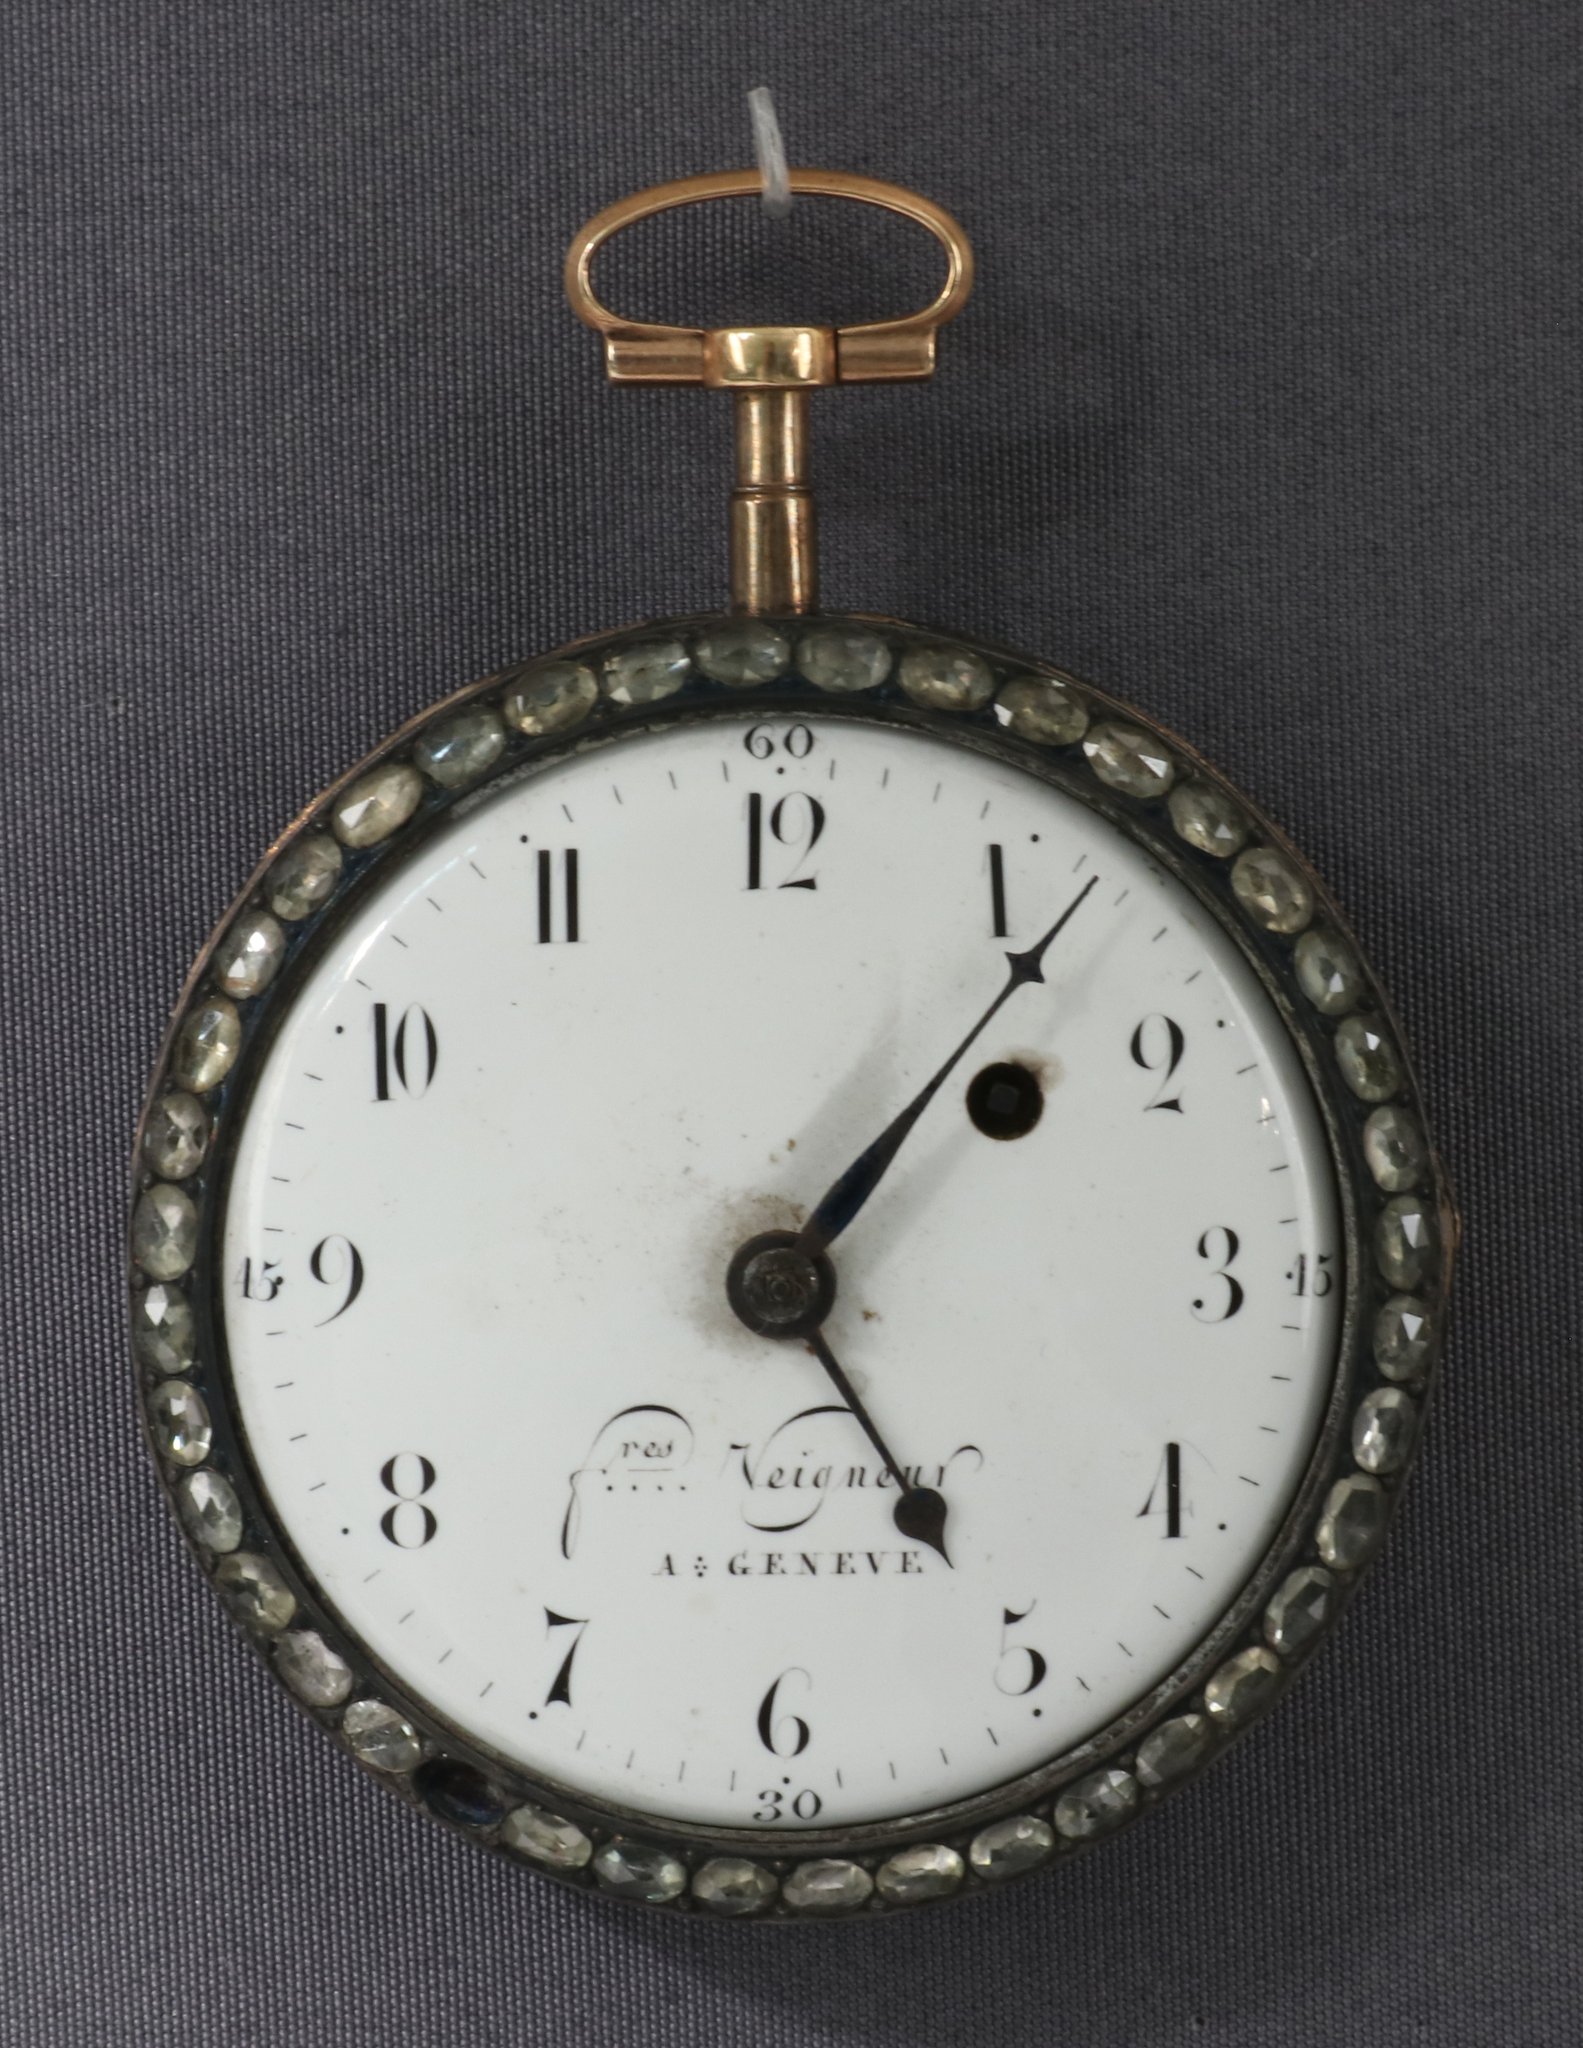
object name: watch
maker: firm of veigneur frères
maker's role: maker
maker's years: 1770-1800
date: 1800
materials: enamel, gold, silver, steel